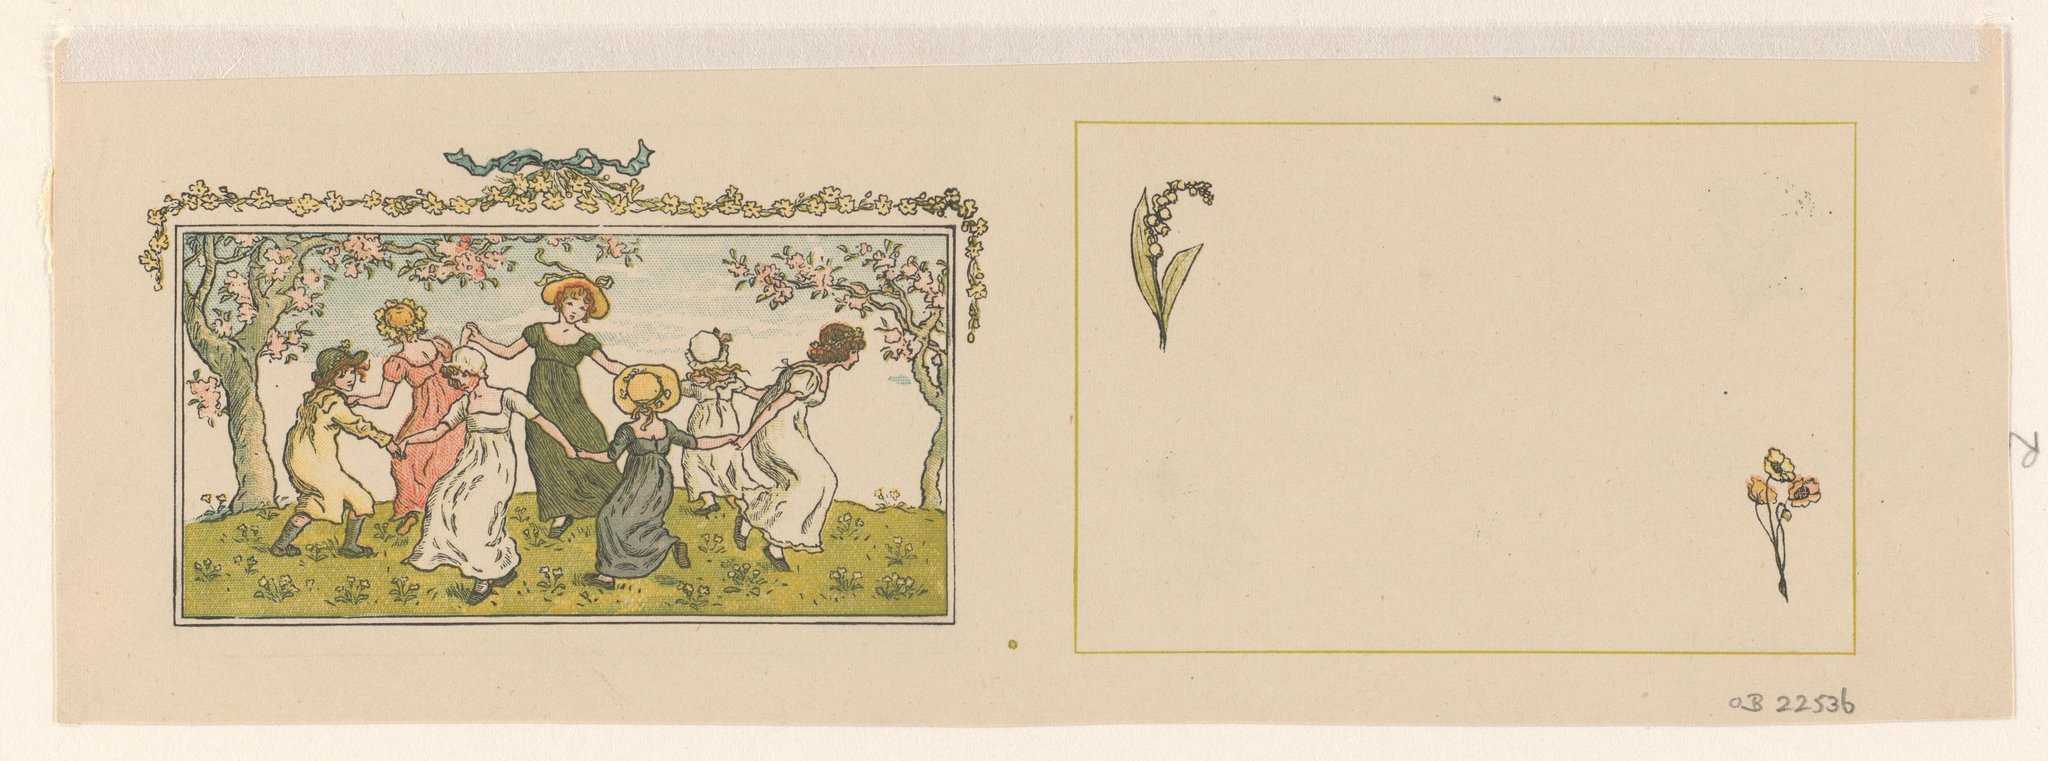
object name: print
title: Figuren dansen in een kring en bloemen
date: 1856-1901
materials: paper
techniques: wood engraving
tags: flowers